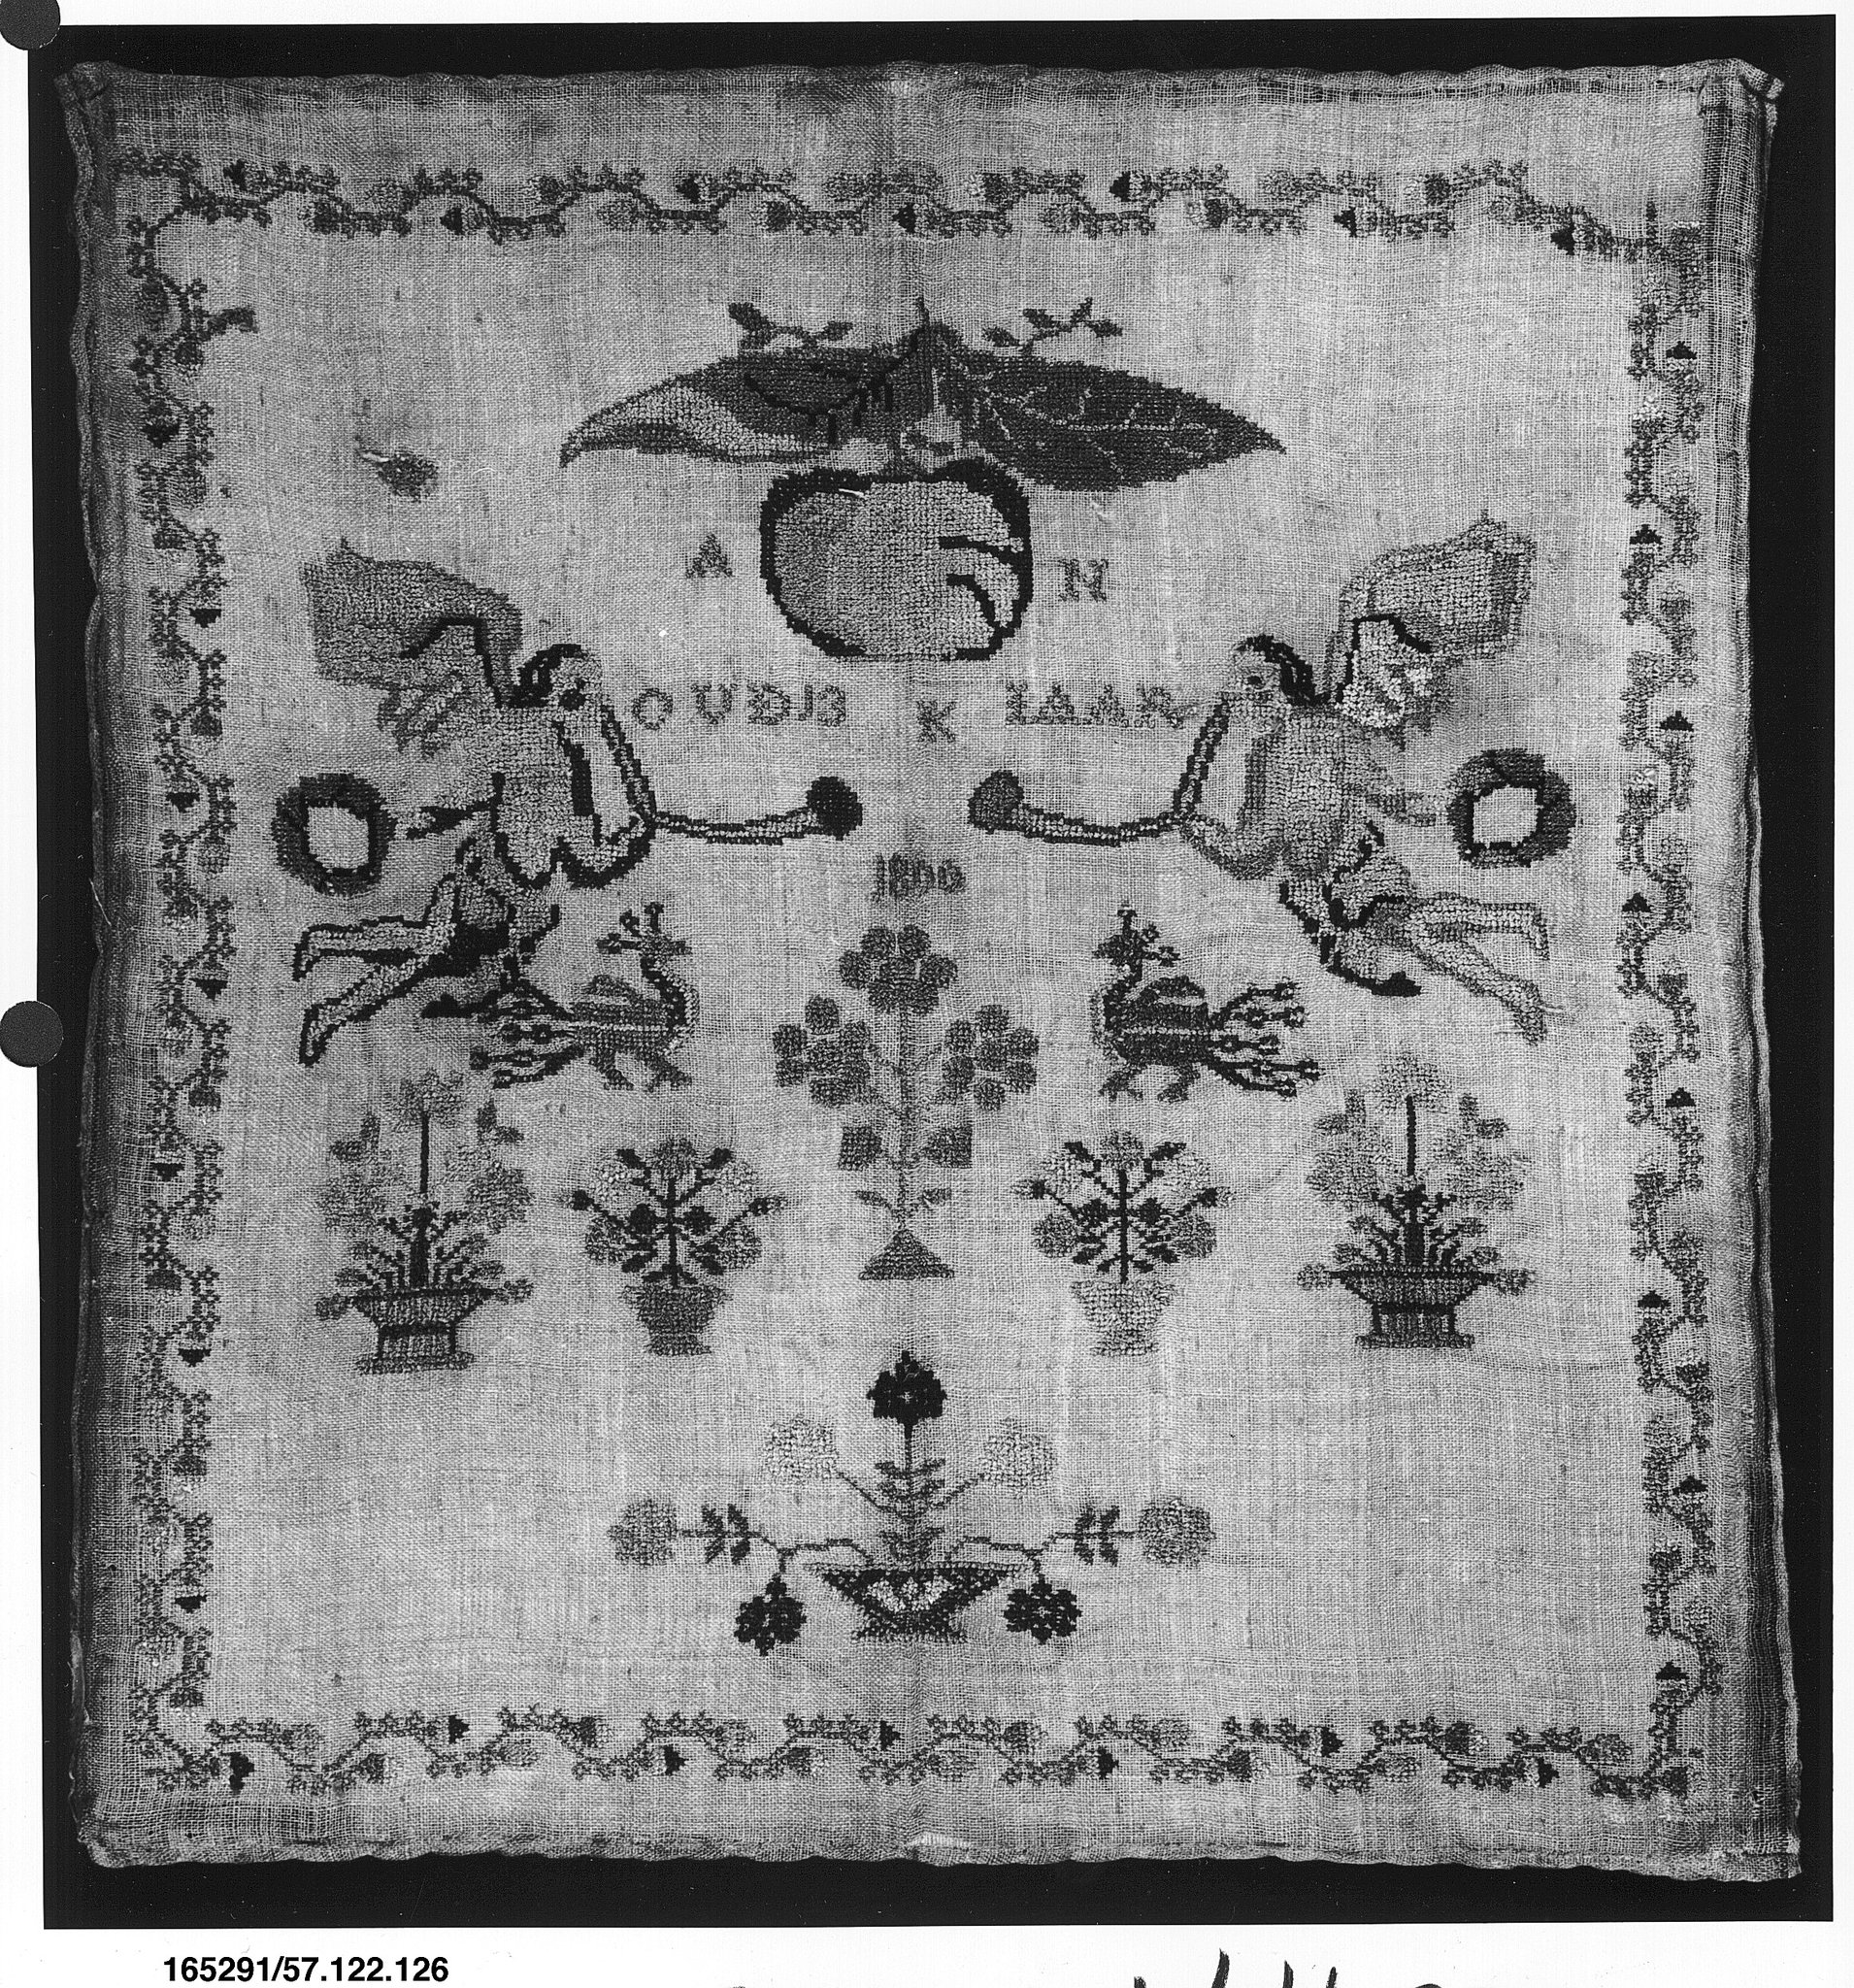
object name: sampler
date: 1800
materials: linen, silk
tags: fruit,peacocks,flowers,angels